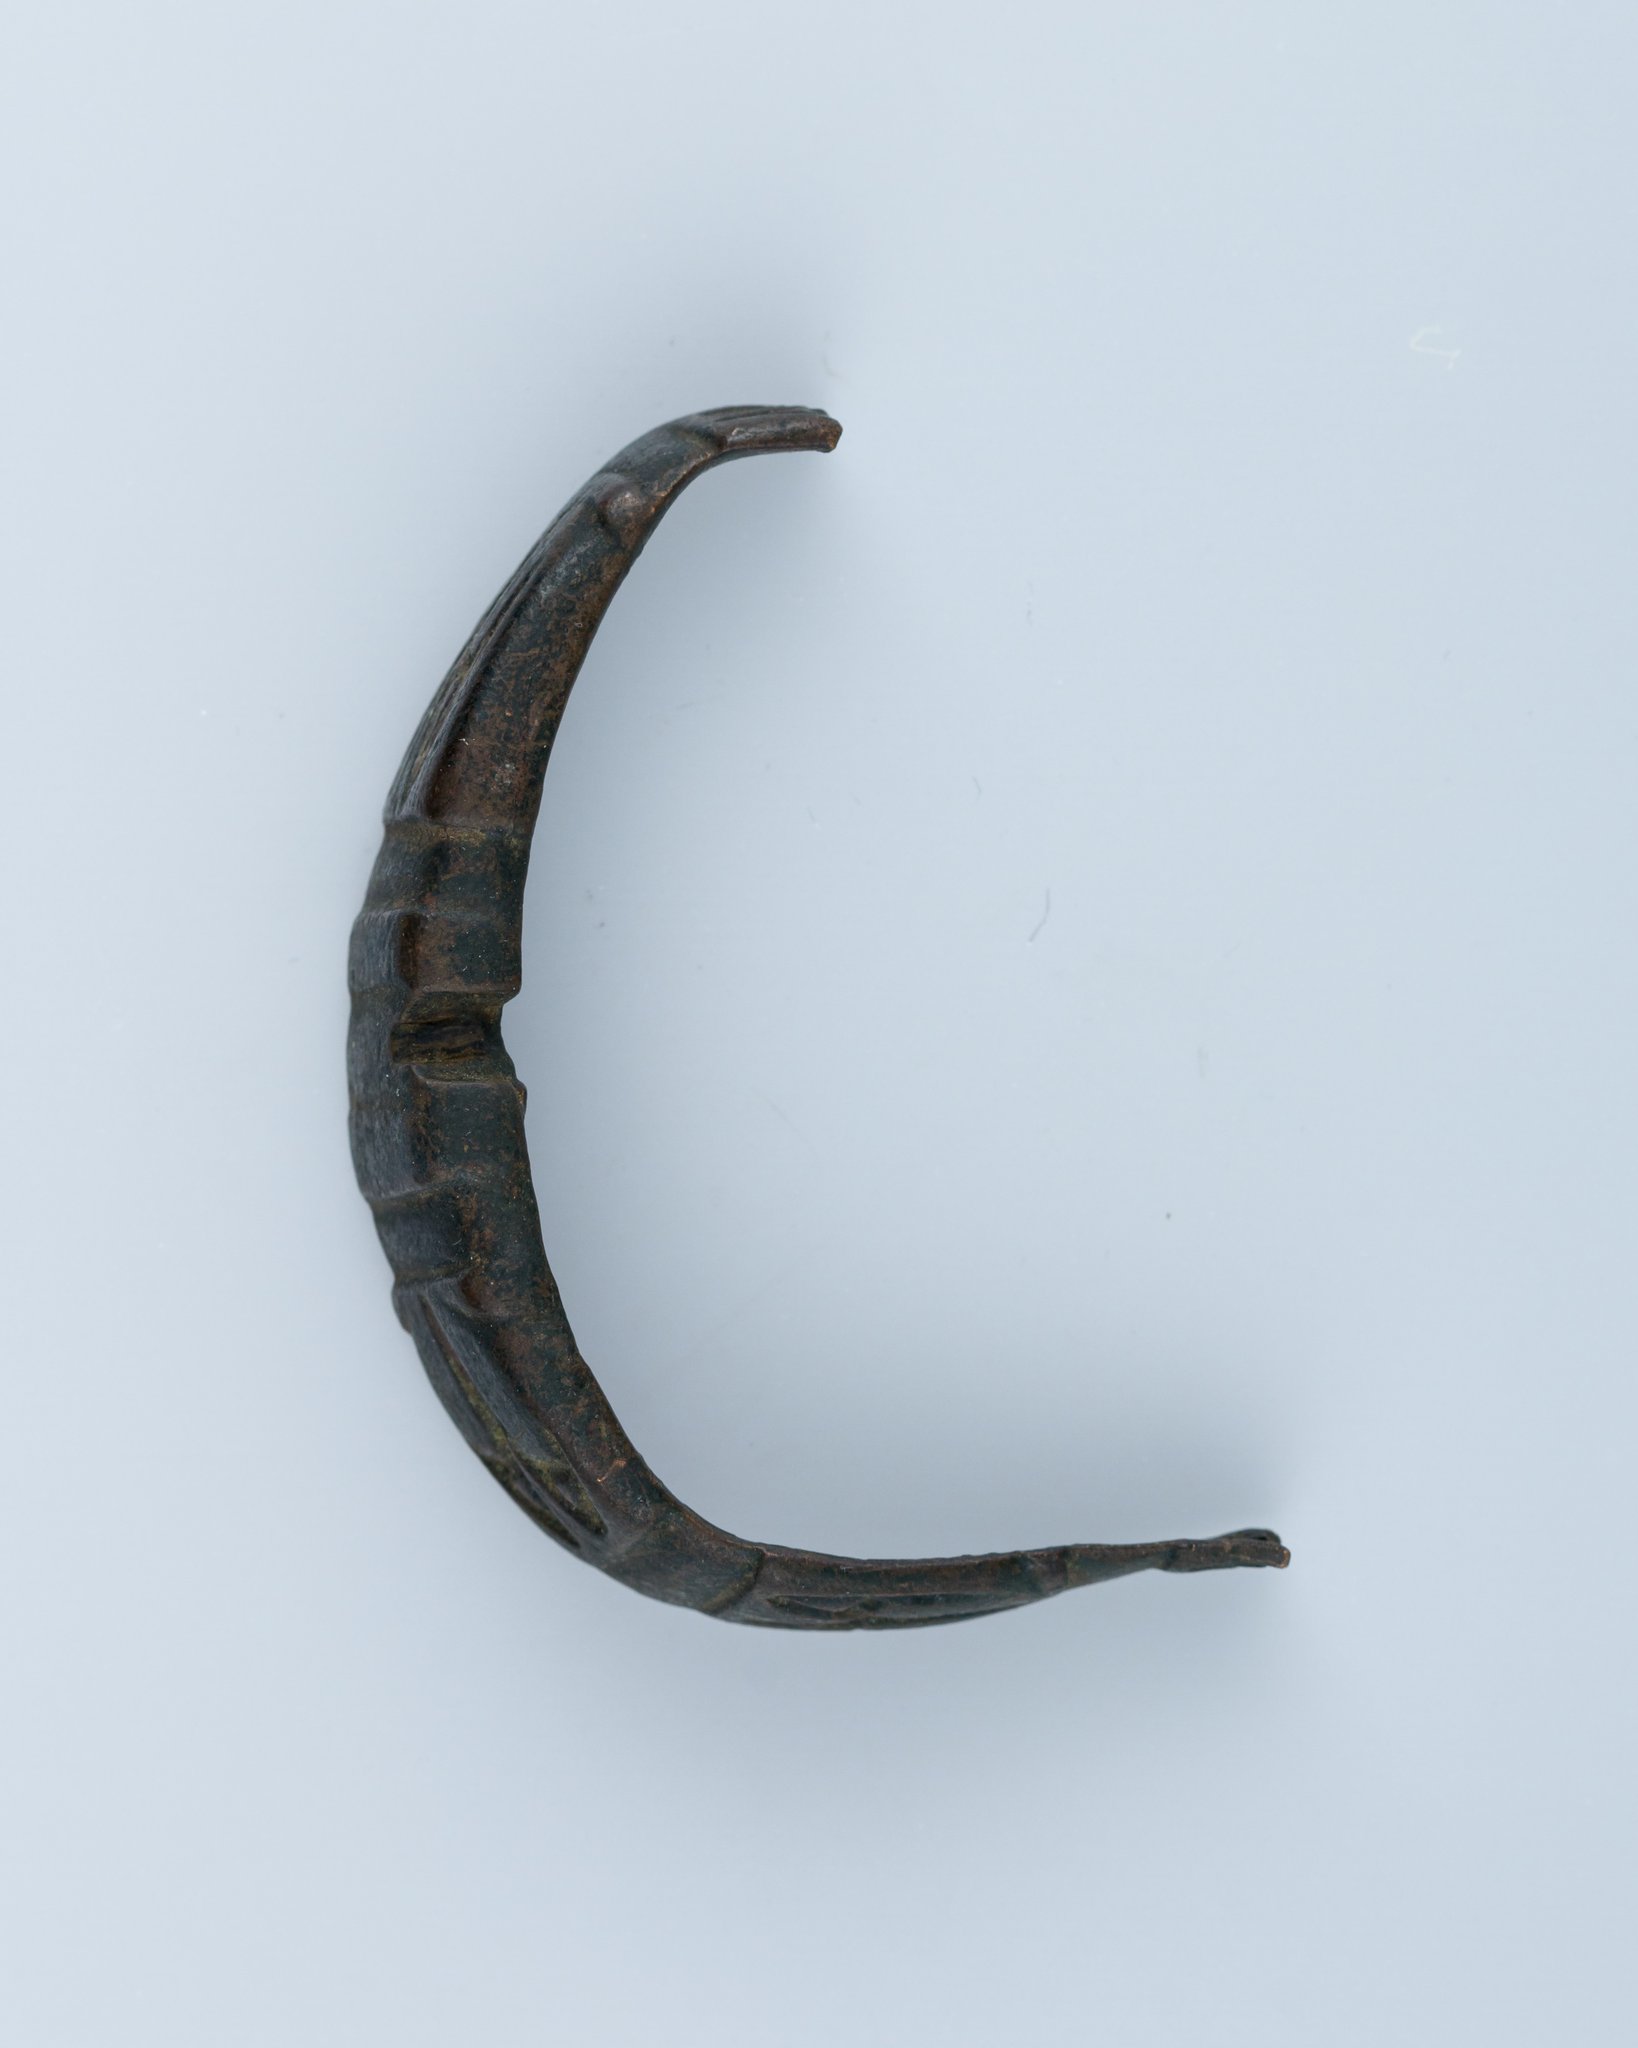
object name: part of a buckle loop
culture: ibero-roman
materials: bronze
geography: spain or portugal